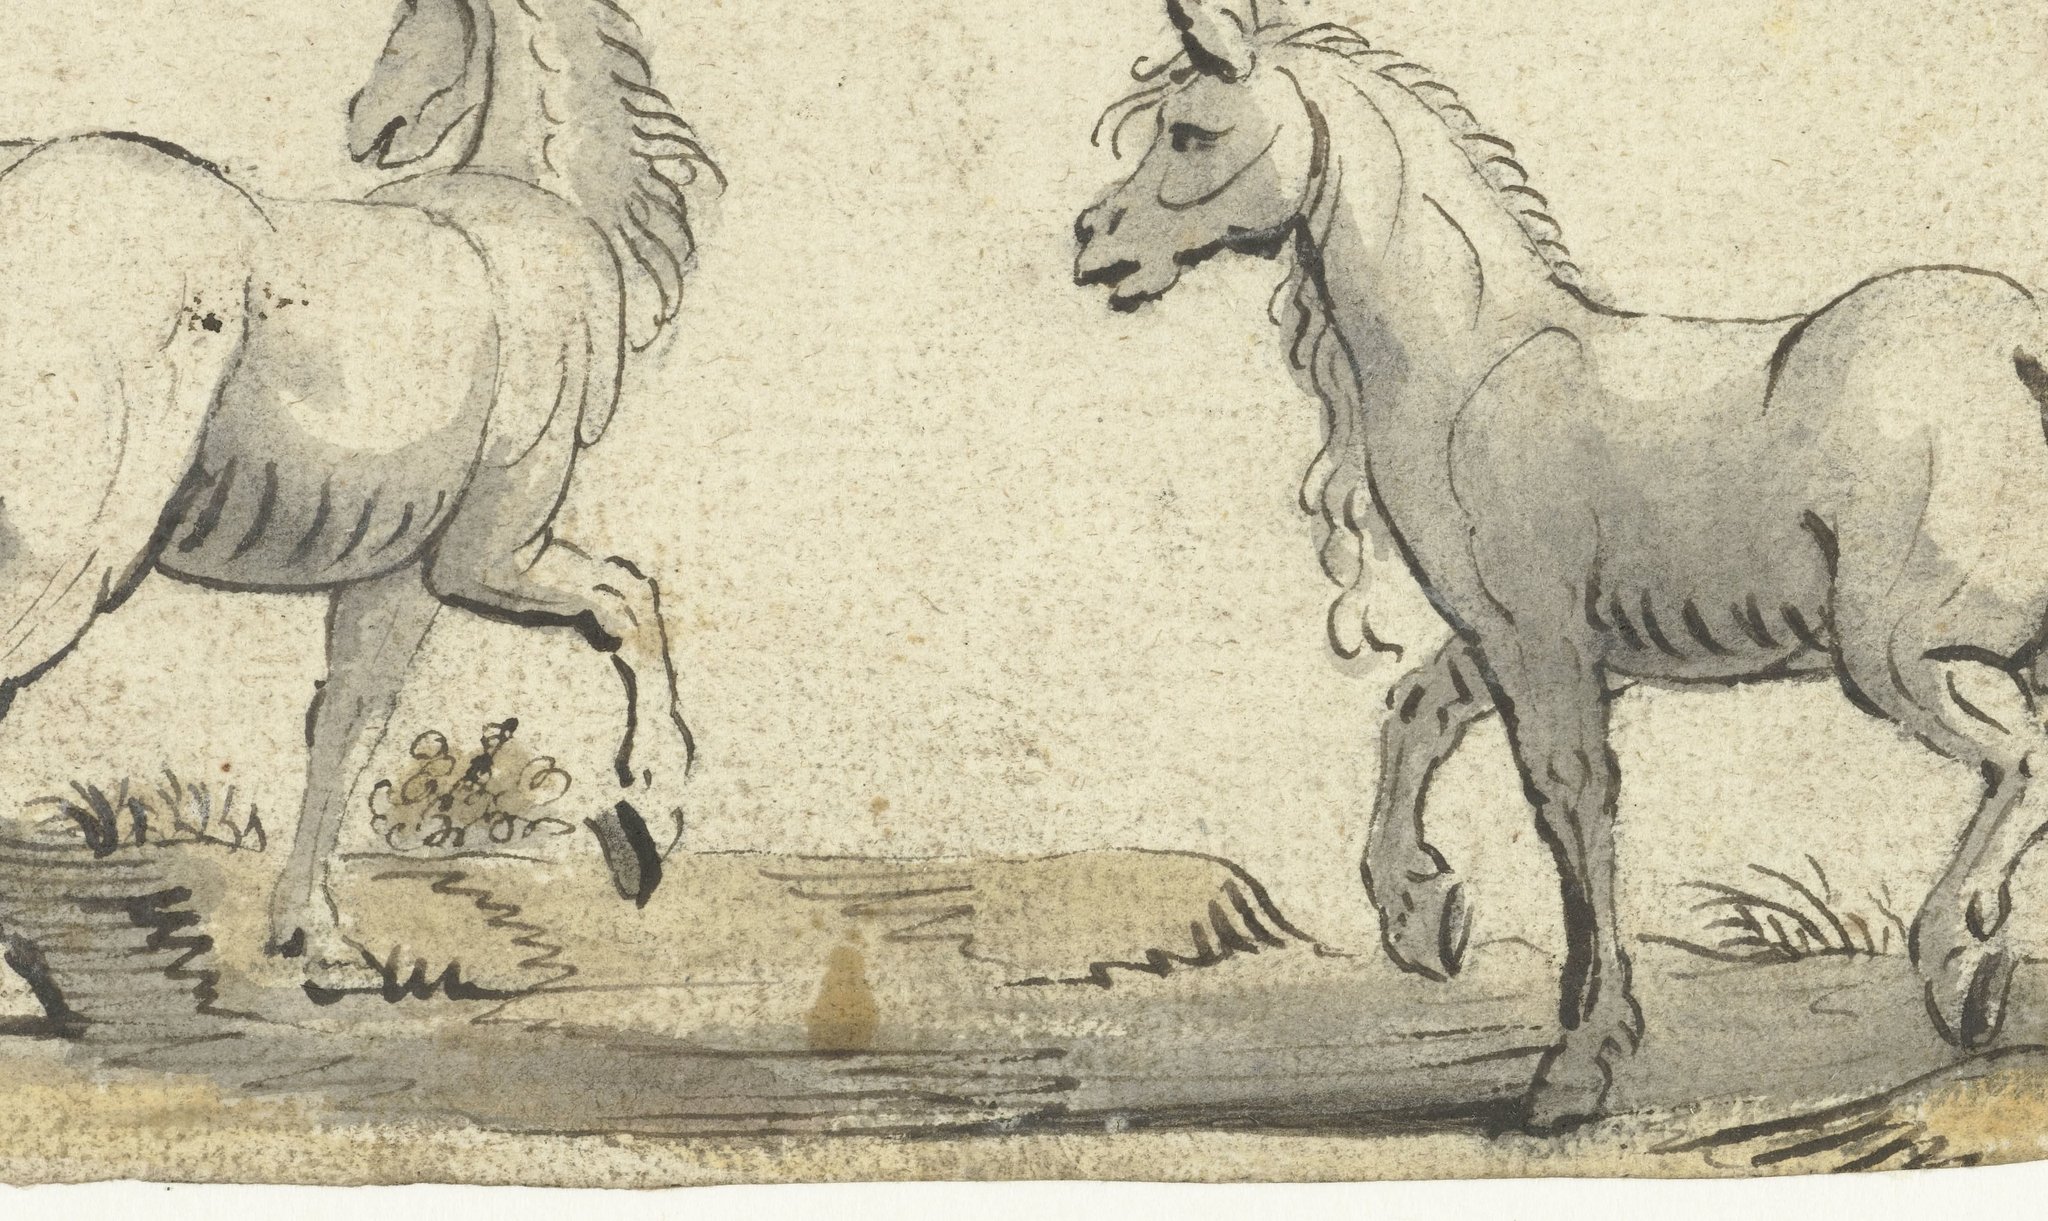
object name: watercolor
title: Twee stapvoets lopende paarden, van opzij gezien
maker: gerard ter borch (i)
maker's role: draughtsman, print maker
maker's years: 1584-1662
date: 1615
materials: ink, paper, watercolor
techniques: brush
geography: zwolle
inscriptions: number: ‘139’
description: Twee prenten uit de serie Paarden in verschillende posities van Antonio Tempesta zijn hier gecombineerd, in spiegelbeeld (vrij naar Antonio Tempesta's prenten Bar. 870 en Bar. 885). Serie nrs 8 en 23 (24).